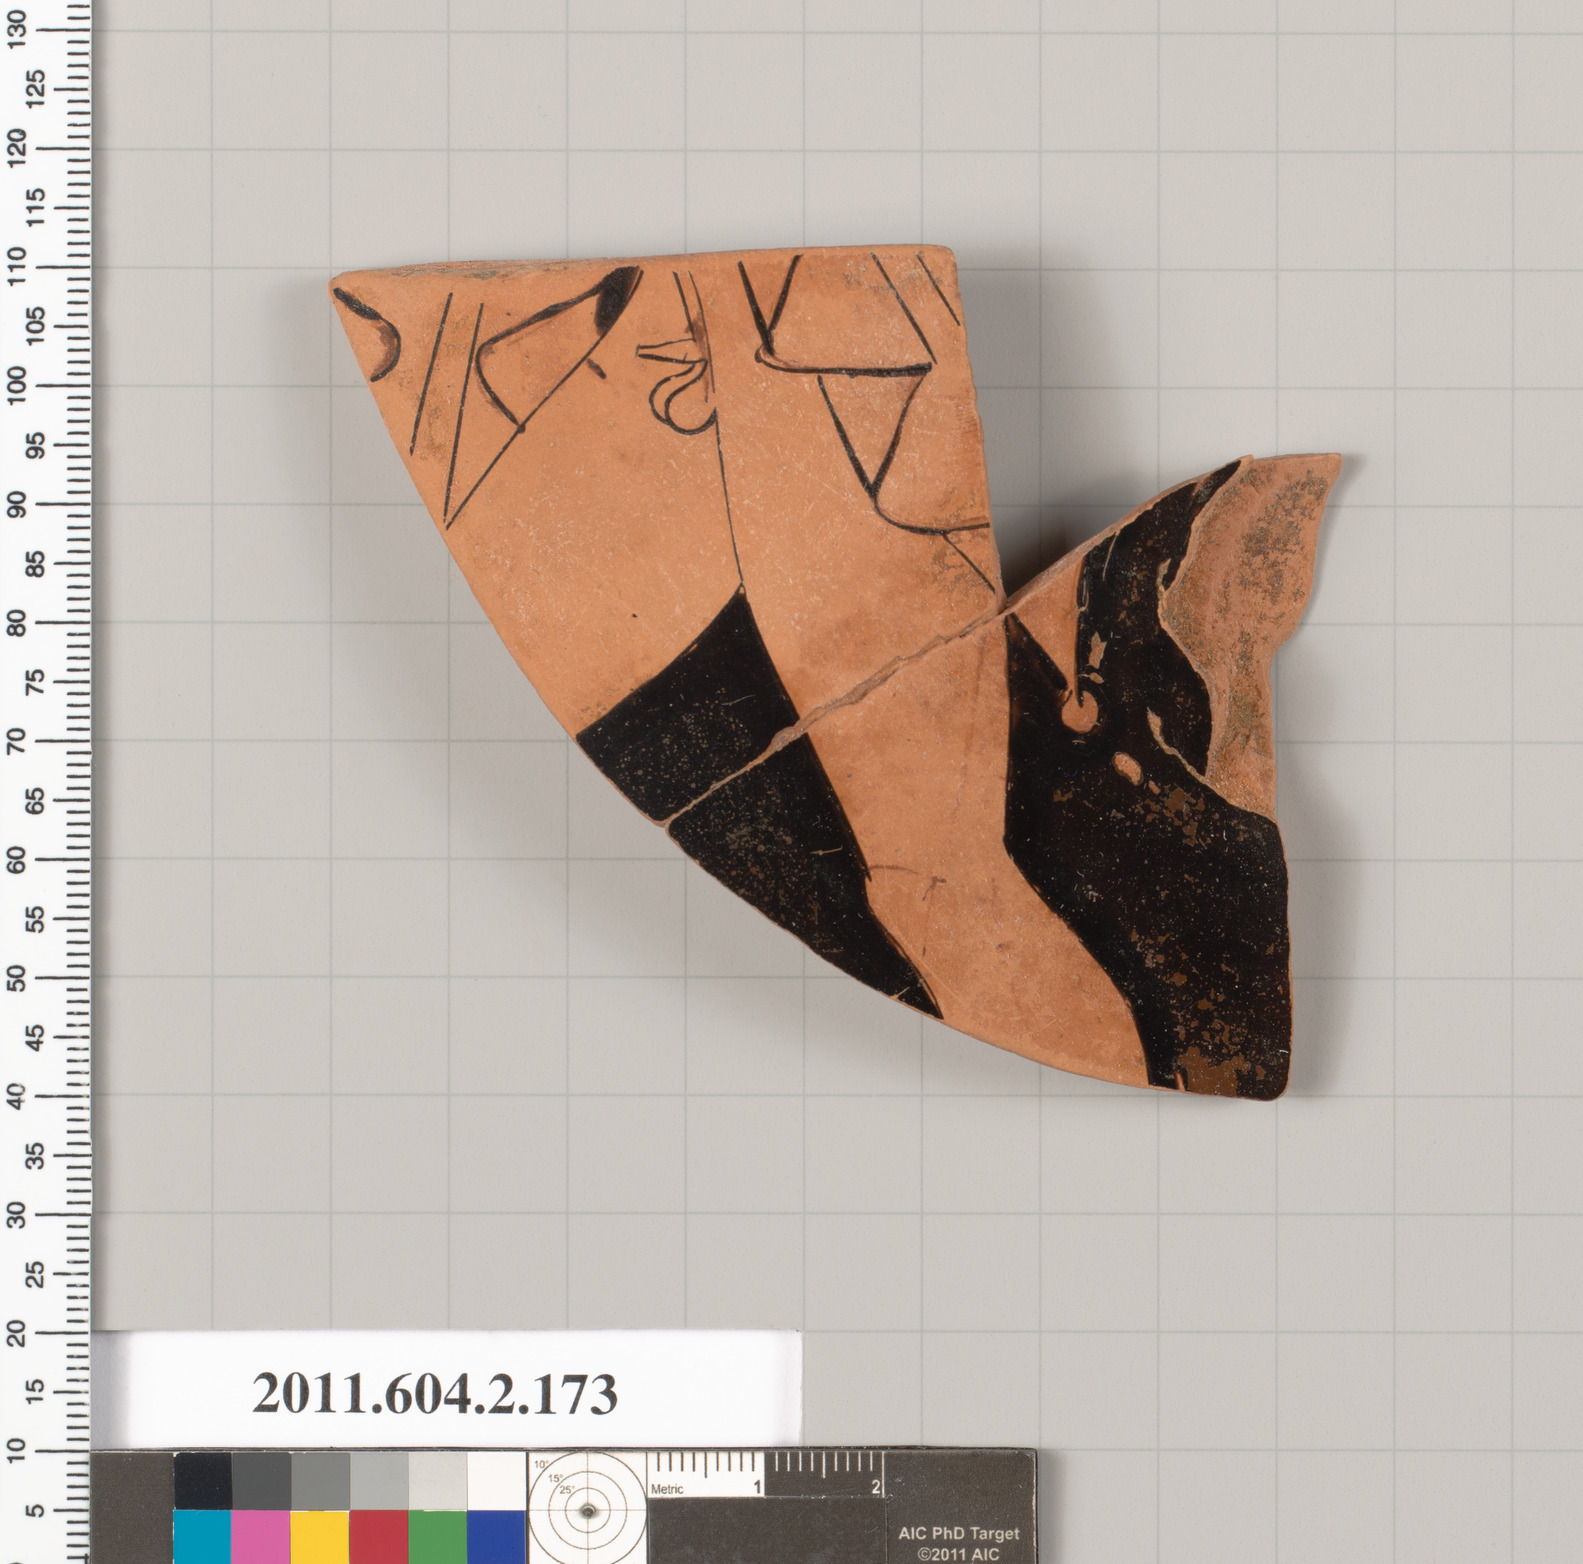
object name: stamnos fragment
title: Terracotta fragment of a stamnos (jar)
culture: greek, attic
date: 500-480 BCE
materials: terracotta